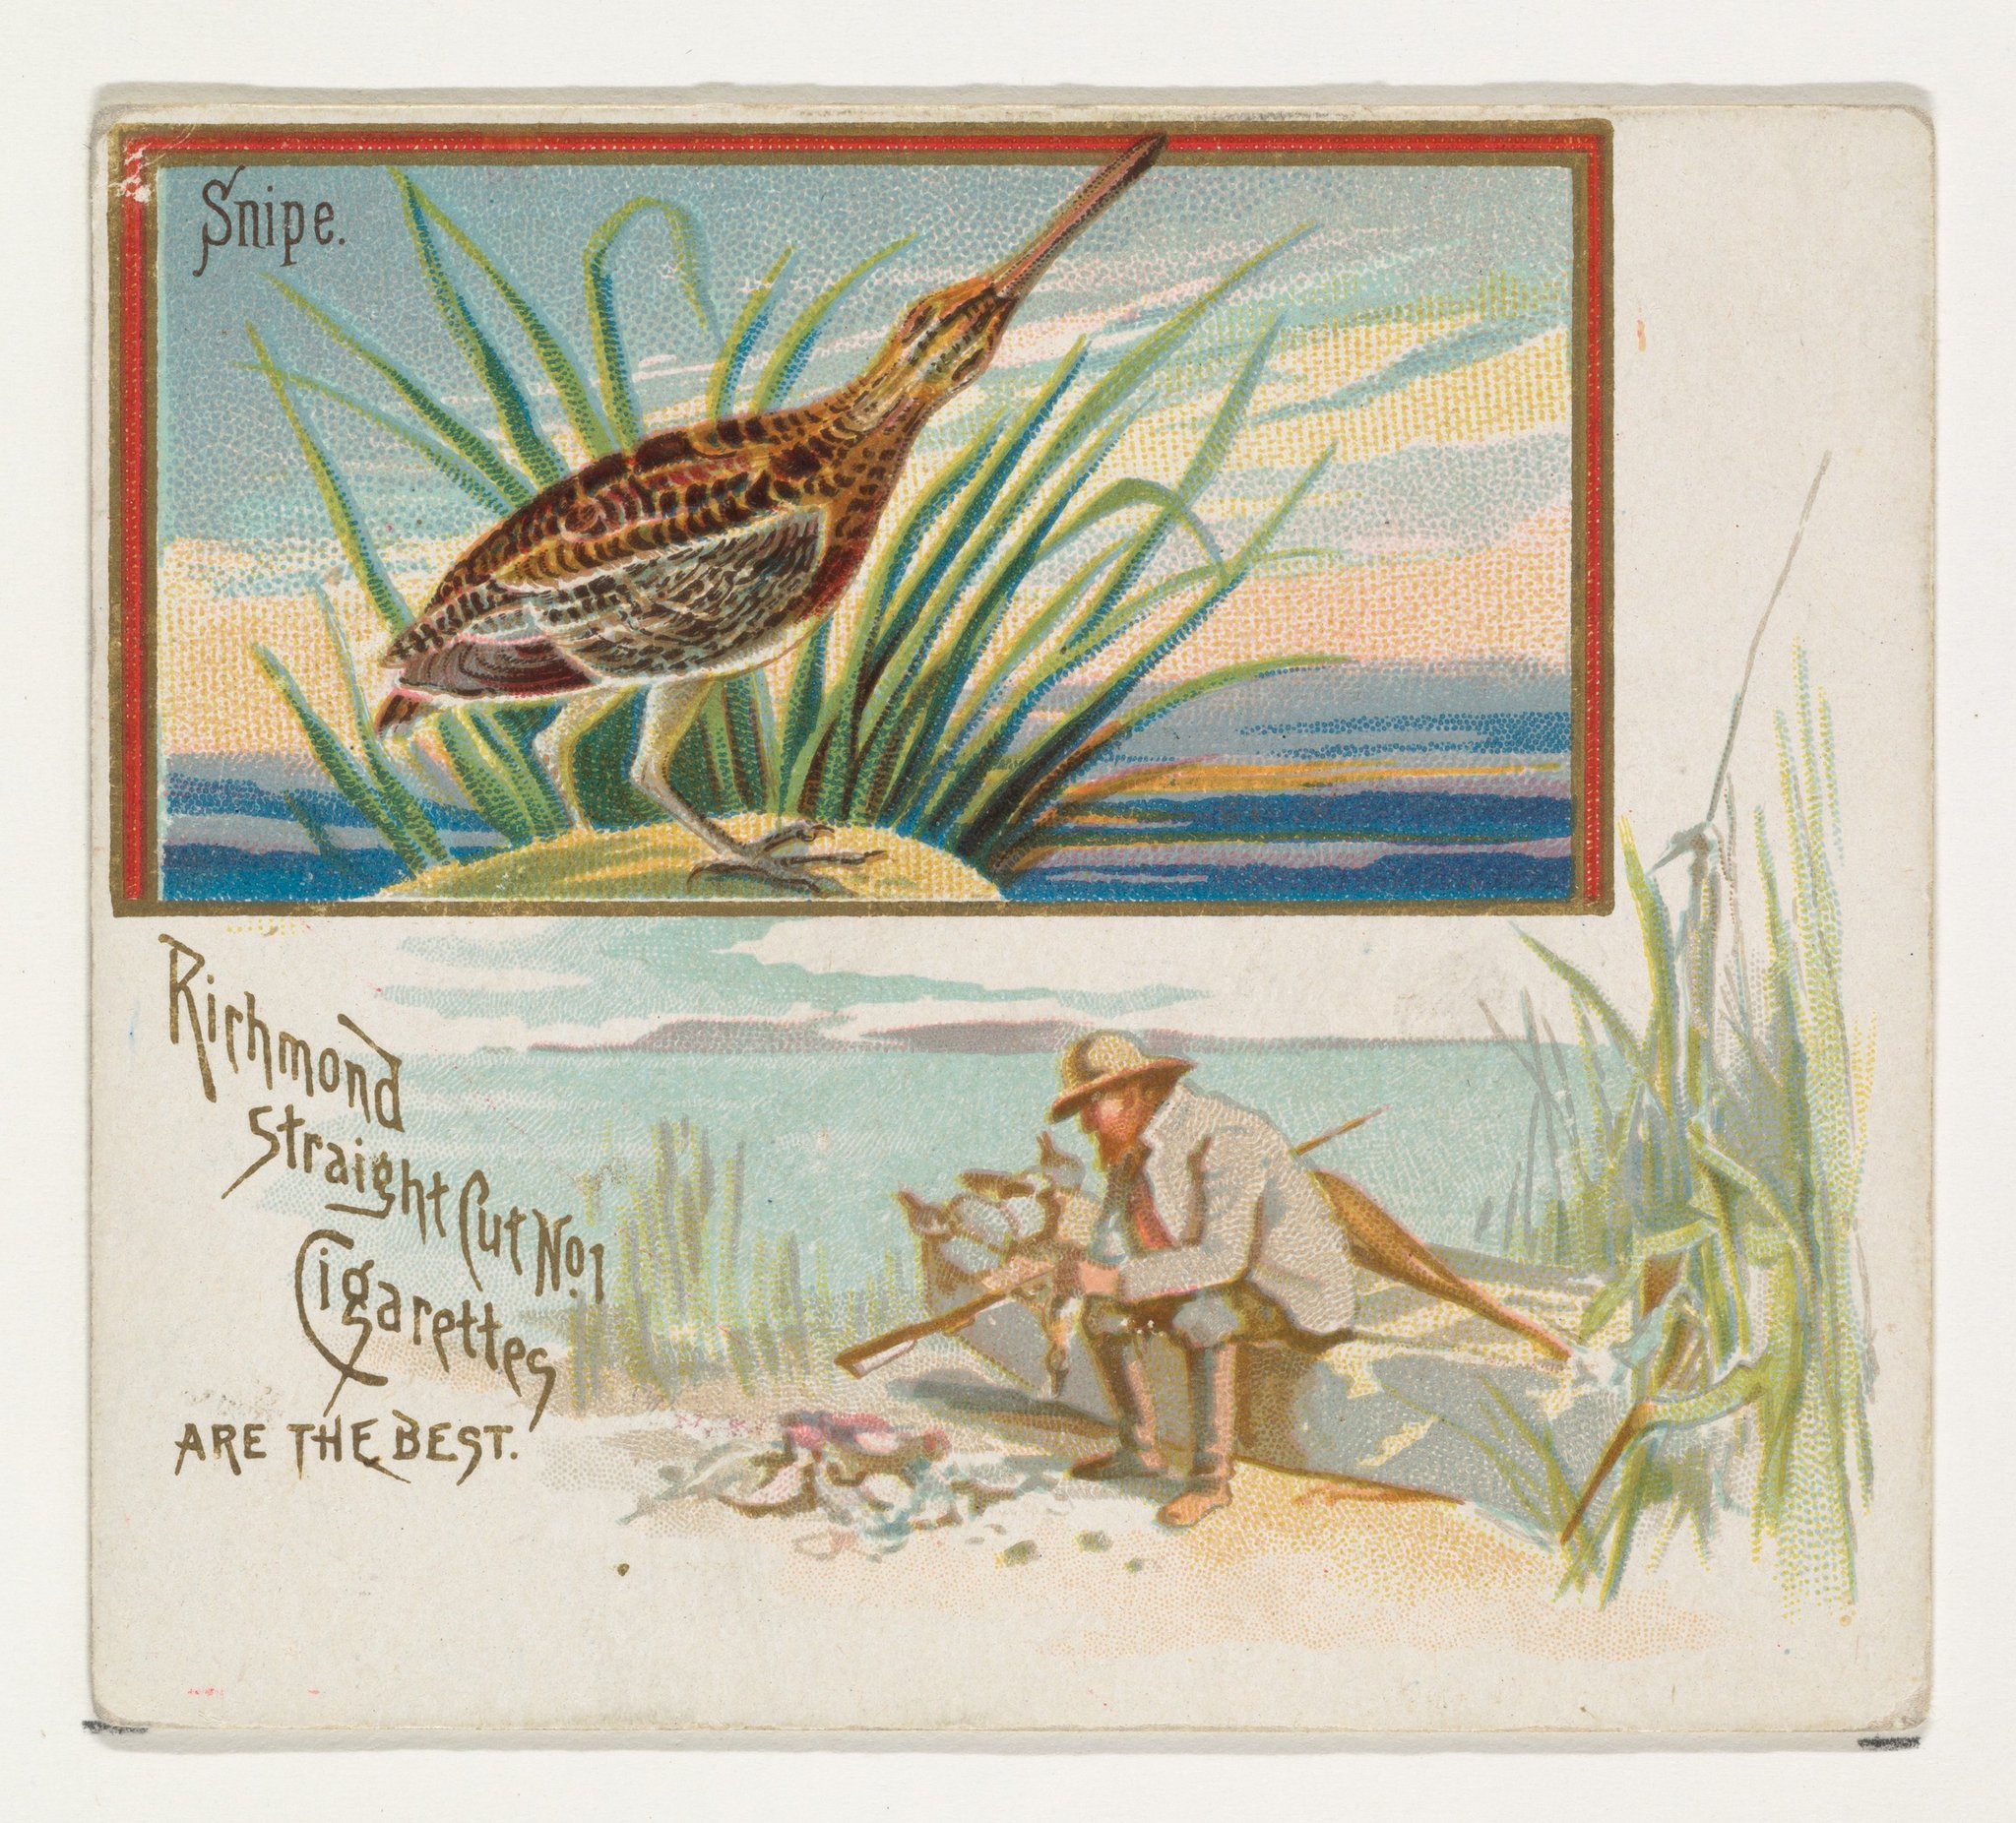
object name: print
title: Snipe, from the Game Birds series (N40) for Allen & Ginter Cigarettes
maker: allen & ginter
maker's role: publisher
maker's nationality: american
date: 1888-1890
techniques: color lithograph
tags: birds